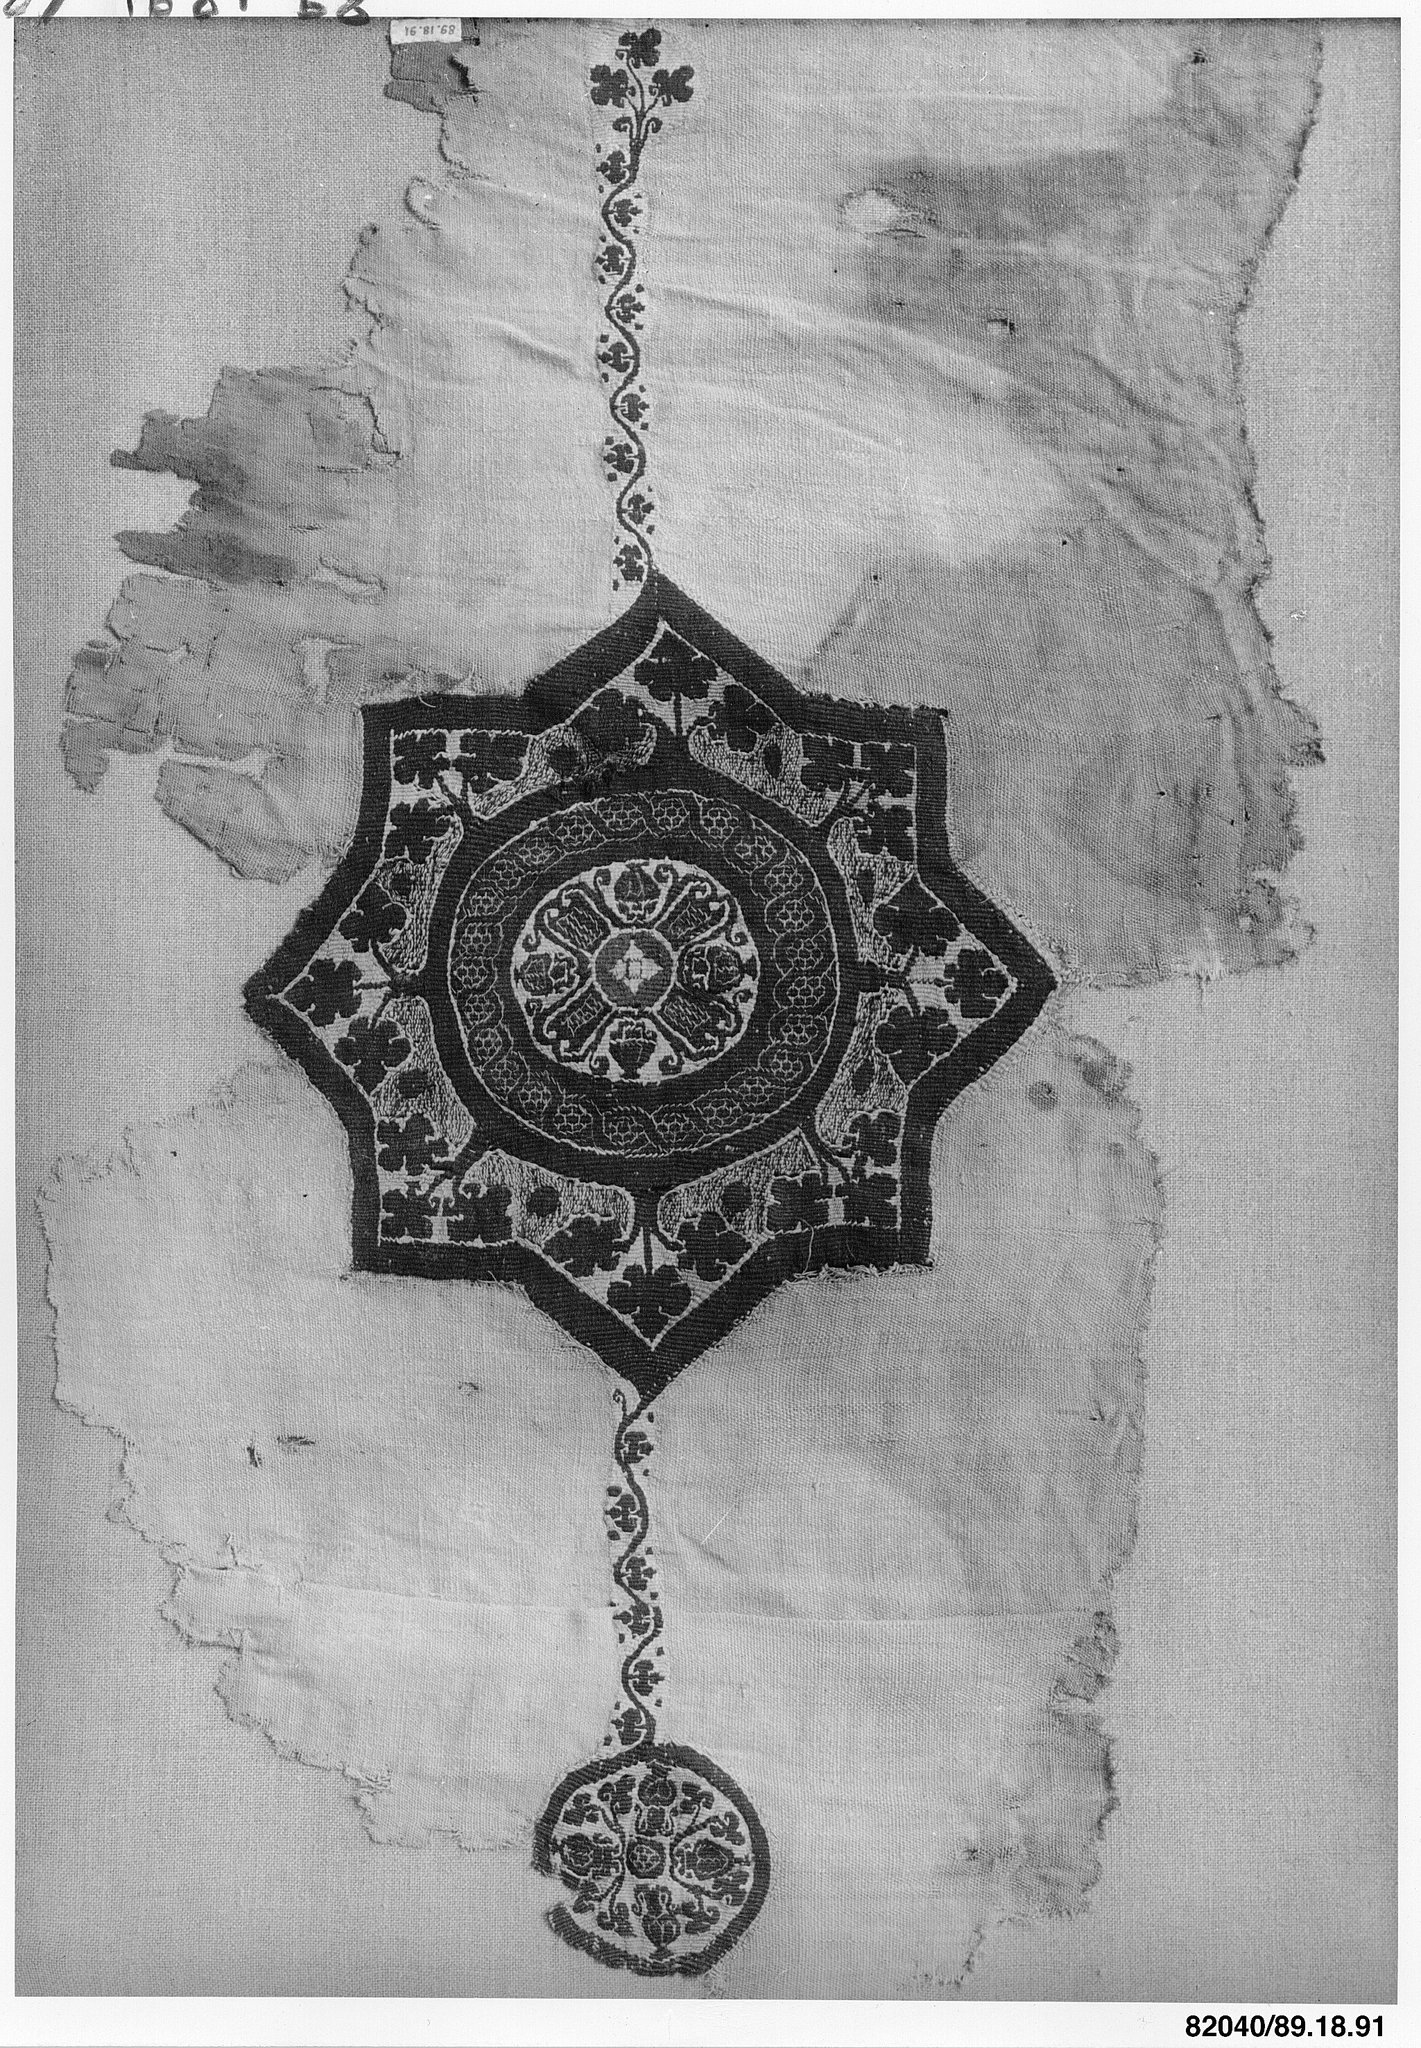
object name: textile fragment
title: Fragment with a Star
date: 301-600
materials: linen, wool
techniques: weave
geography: egypt